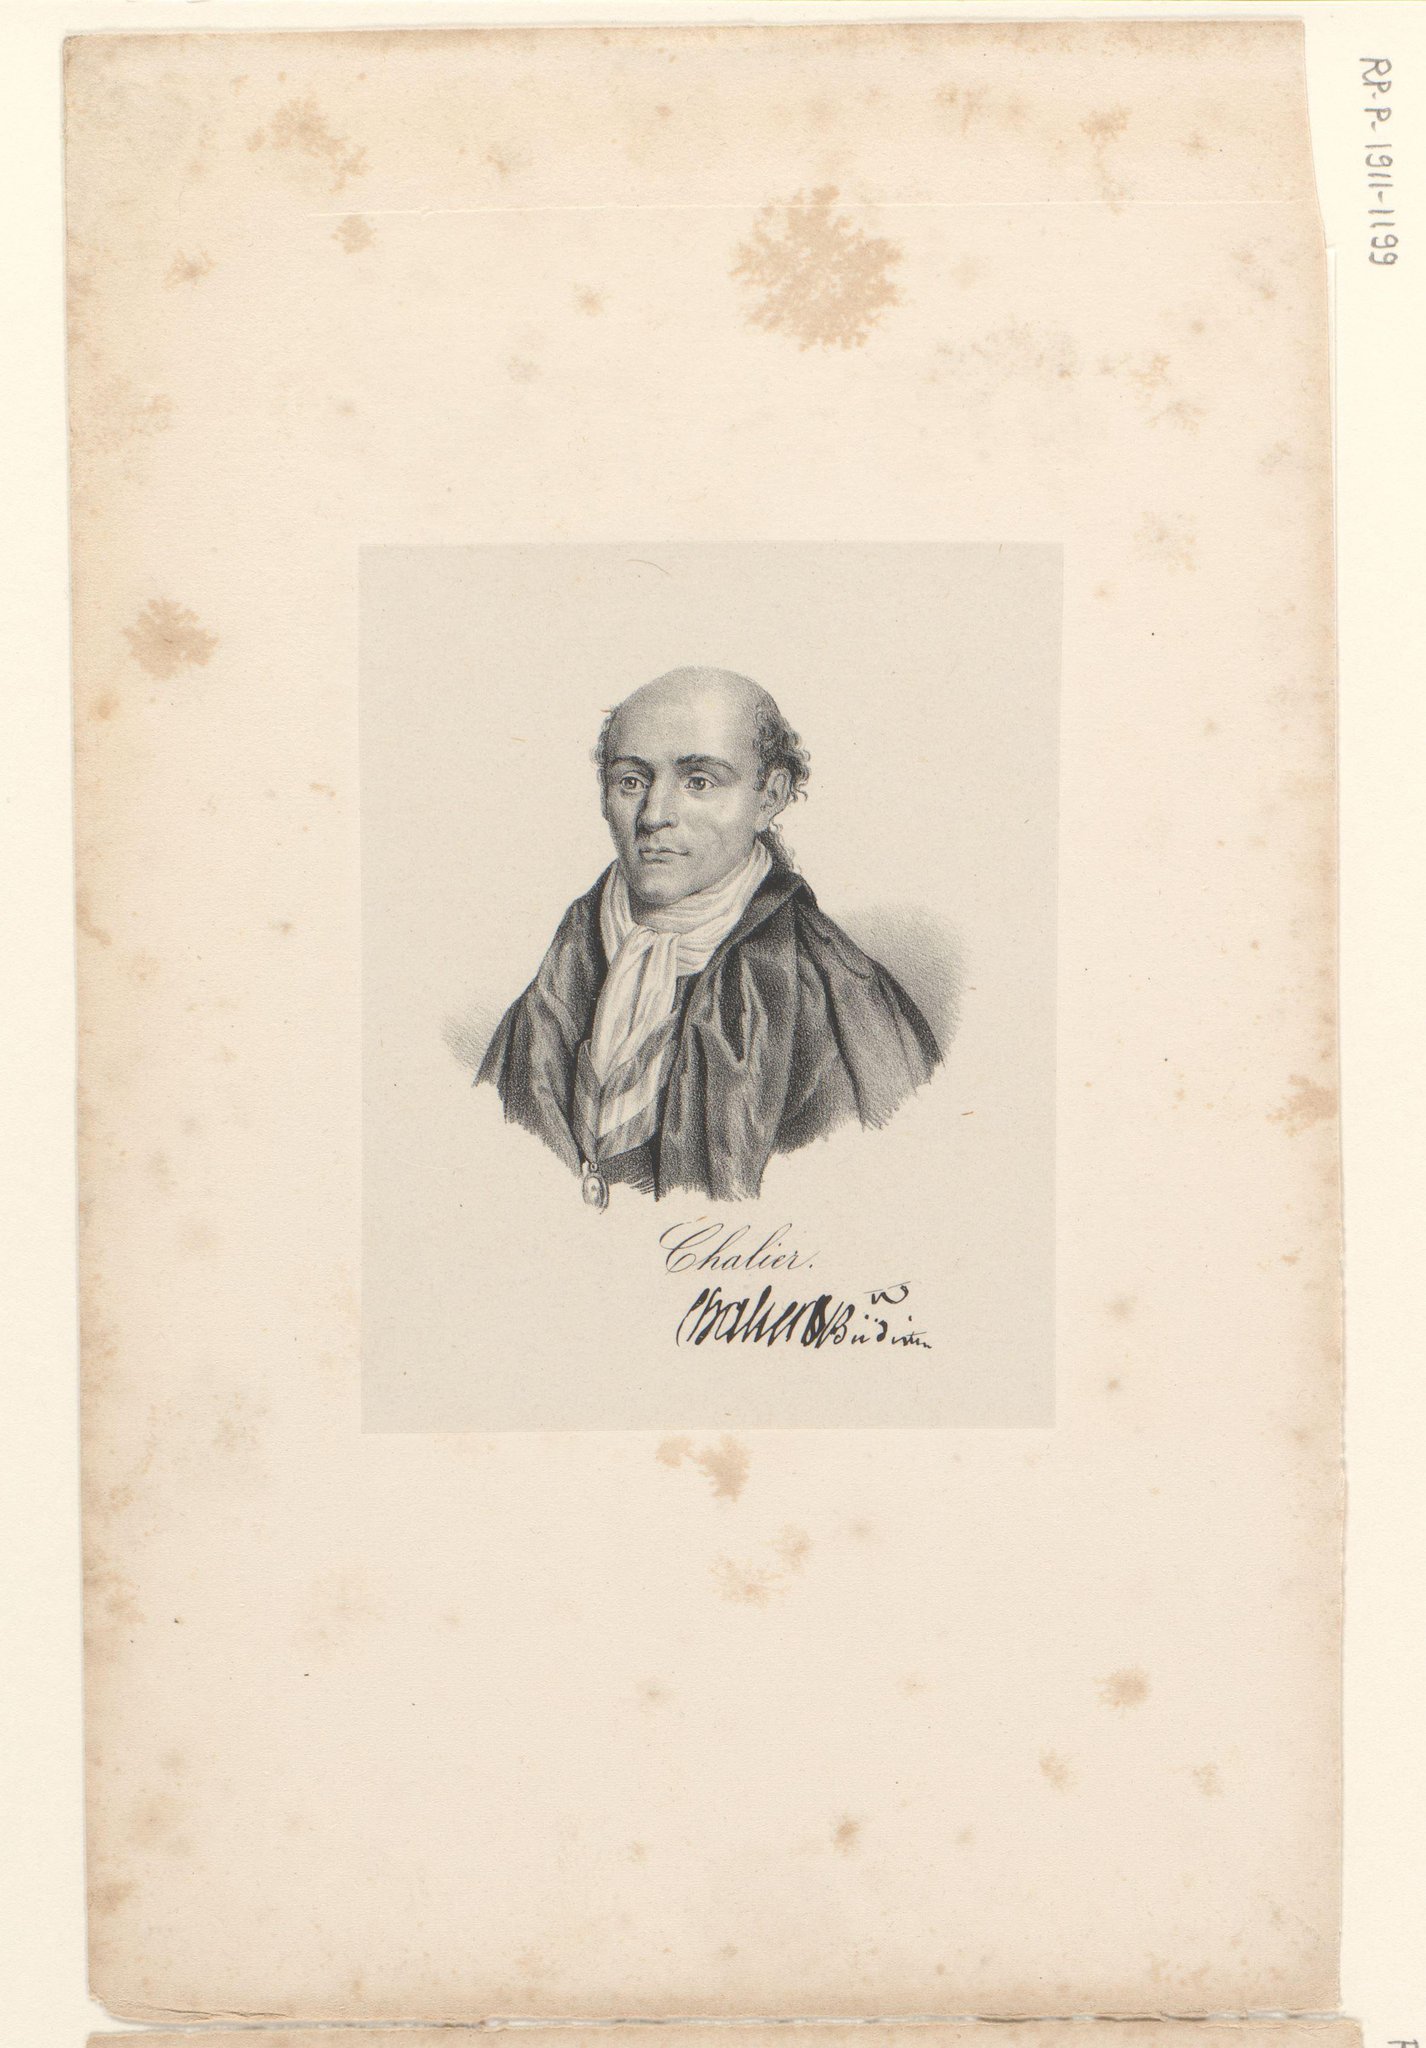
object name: print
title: Chalier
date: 1818-1842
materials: paper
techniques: lithograph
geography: paris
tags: historical persons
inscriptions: collector's mark: Lugt 2228a